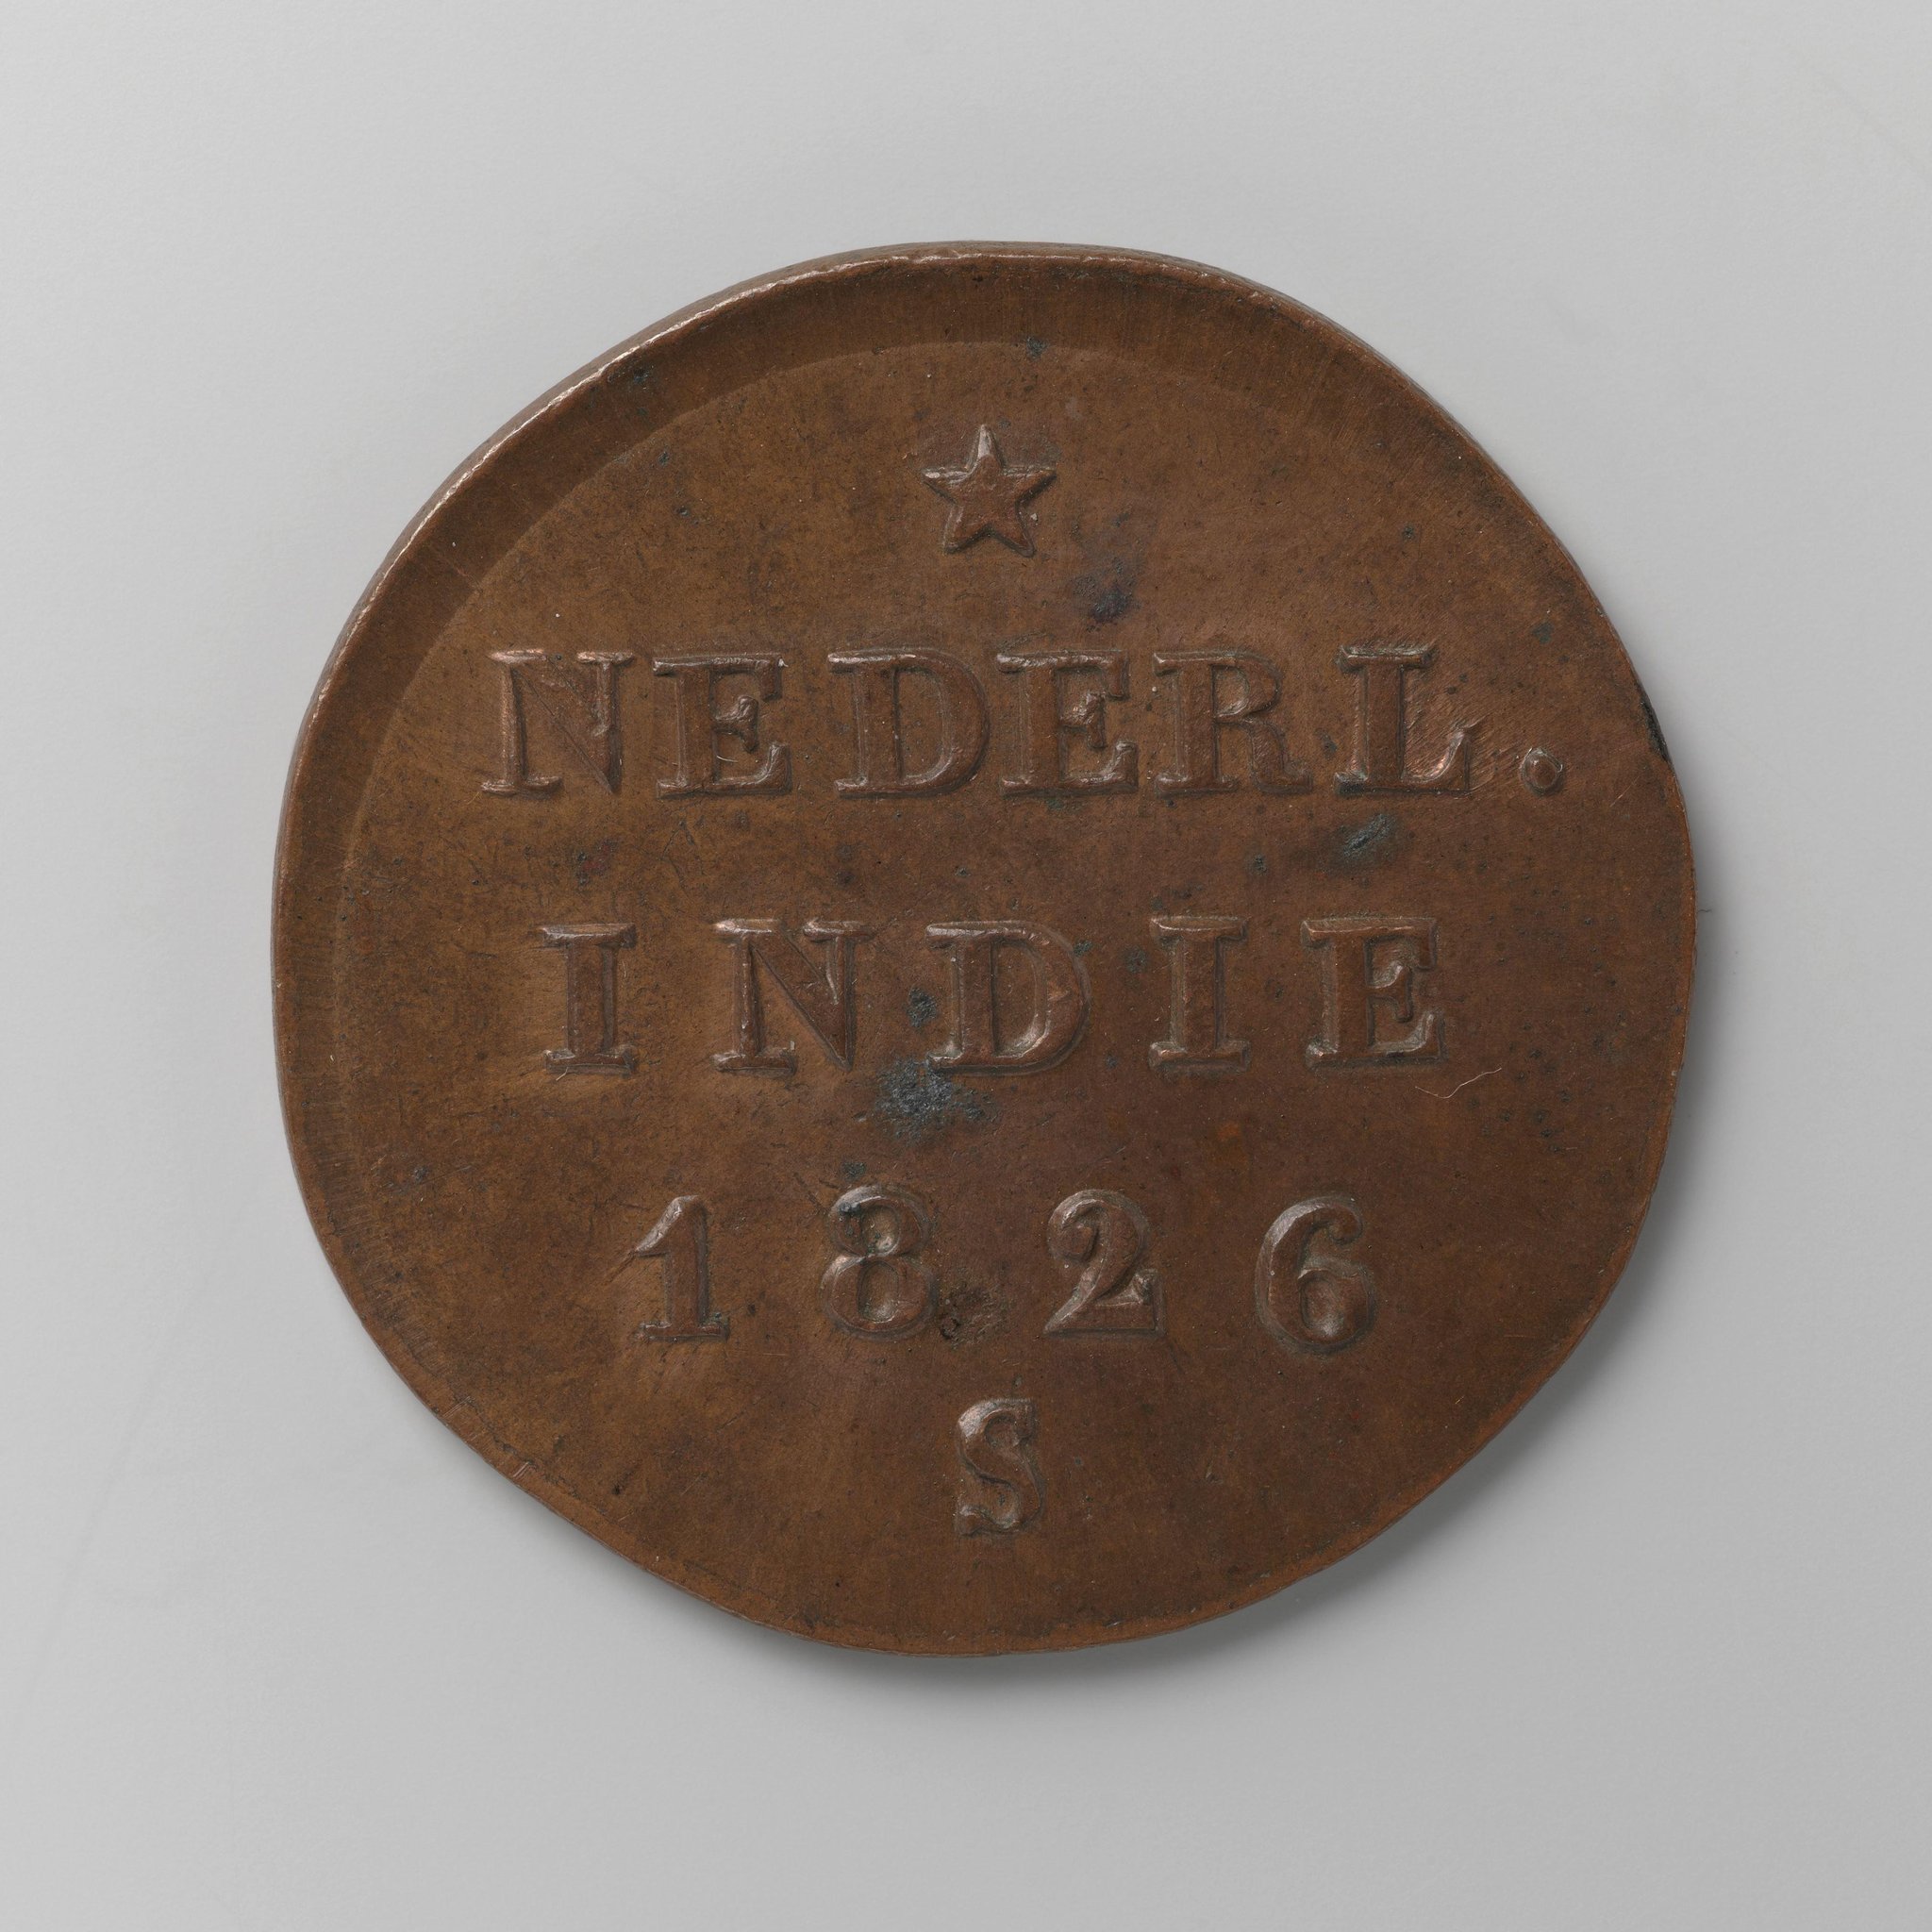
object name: coin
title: ½ stuiver van Nederlands Indië, 1826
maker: william i of the netherlands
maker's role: koning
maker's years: 1772-1843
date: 1826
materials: copper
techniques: striking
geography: utrecht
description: Koperen munt. Voorzijde: tussen waarde-aanduiding ½ St. gekroond rijkswapenschild. Keerzijde: tweeregelig opschrift, waarboven muntteken en waaronder jaartal. Daaronder muntmeesterteken S [=Suermondt]. Gladde rand.